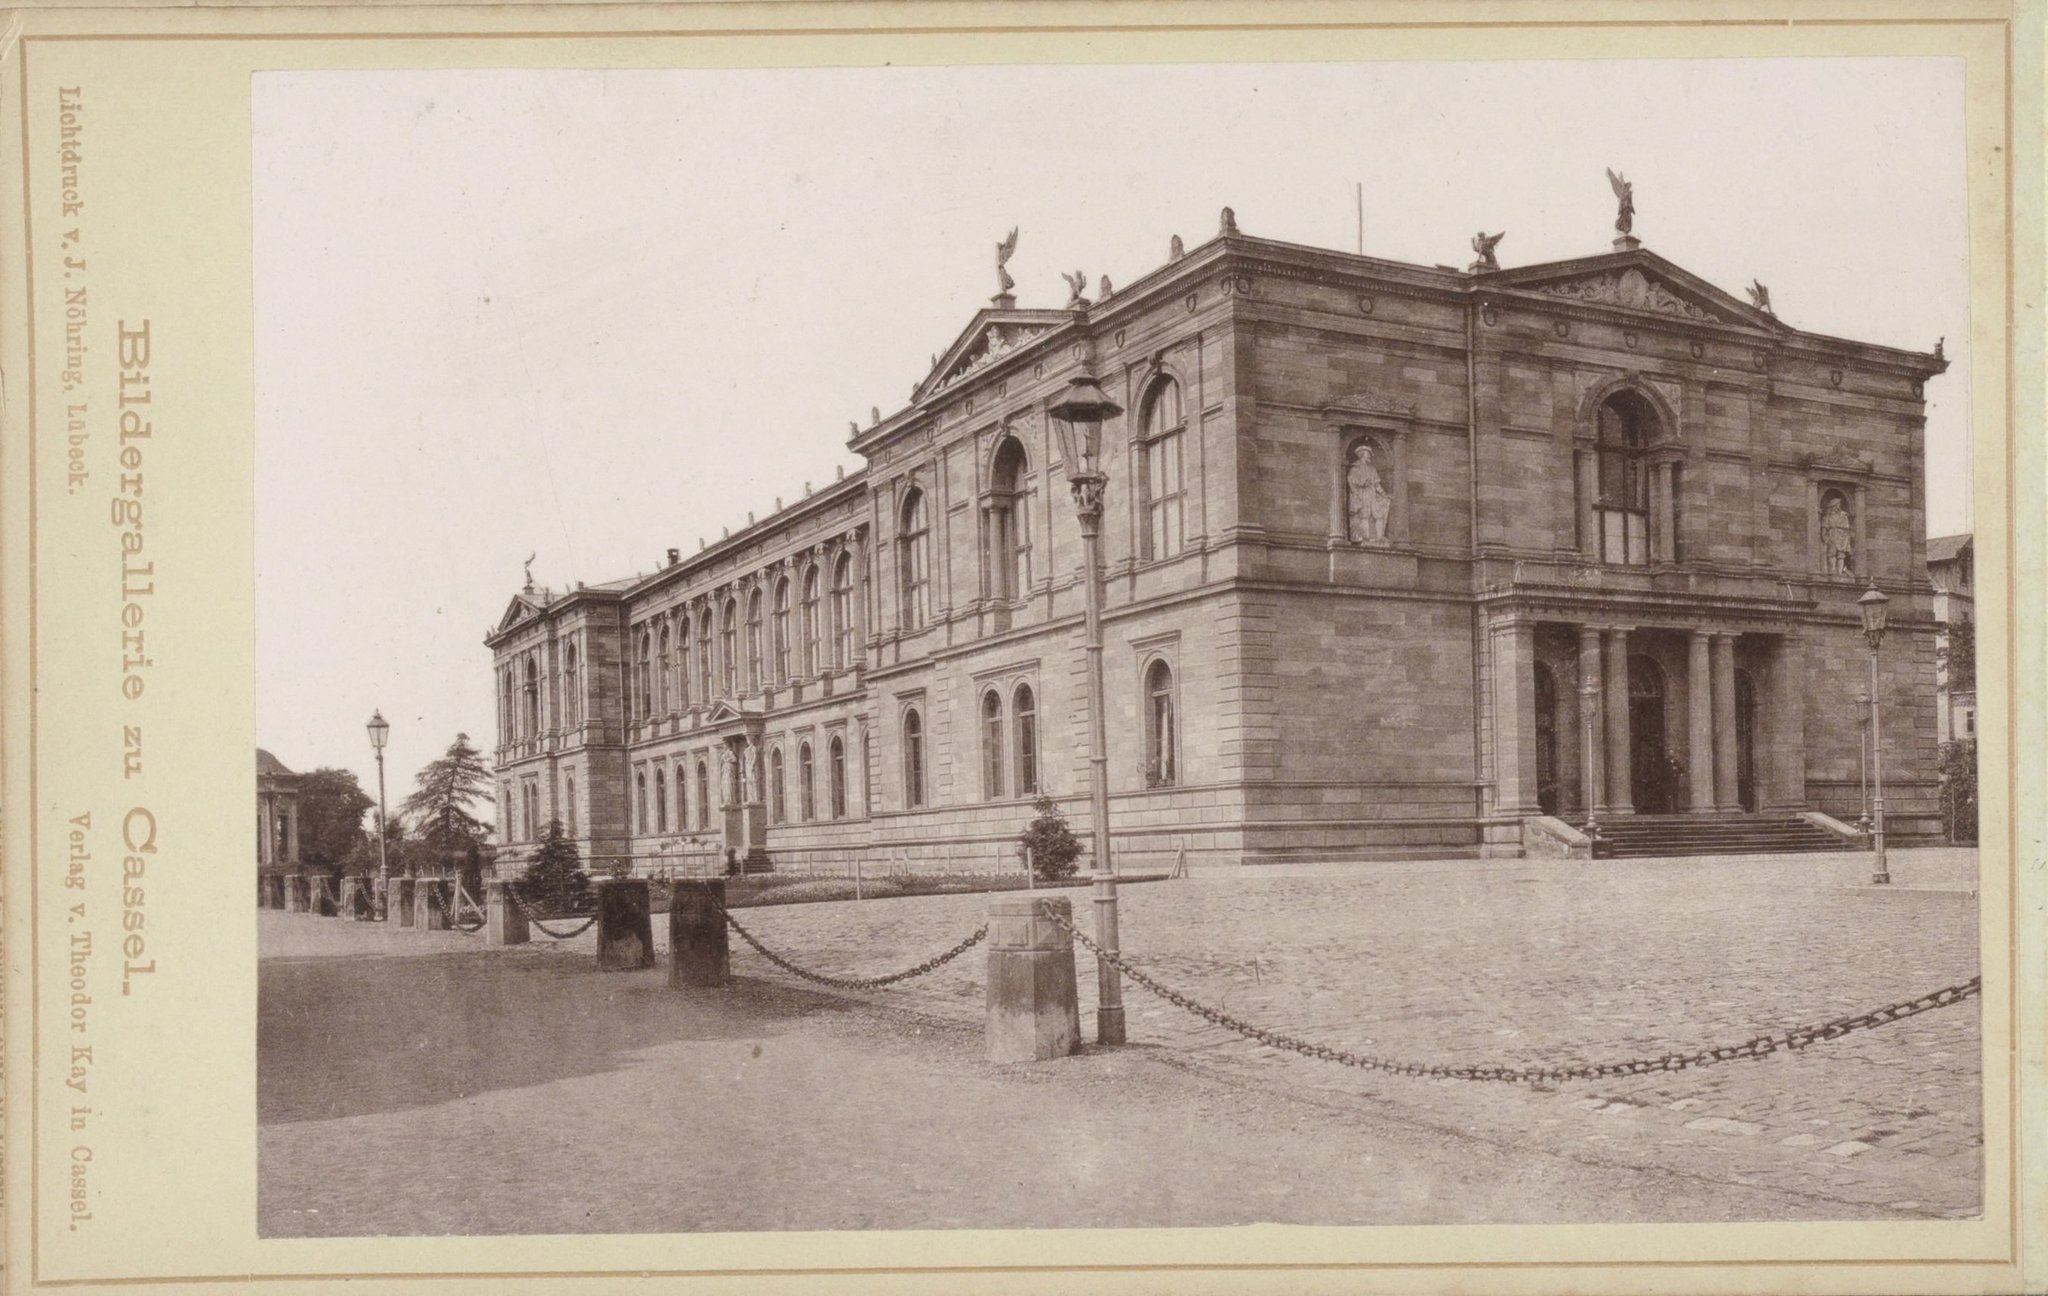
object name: cabinet photograph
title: Exterieur van de Bildergalerie in Kassel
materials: cardboard, paper, photographic support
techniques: photograph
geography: kassel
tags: travelling; tourism, permanent exhibition, museum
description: Onderdeel van Album met 38 foto's van een reis door de Harz.